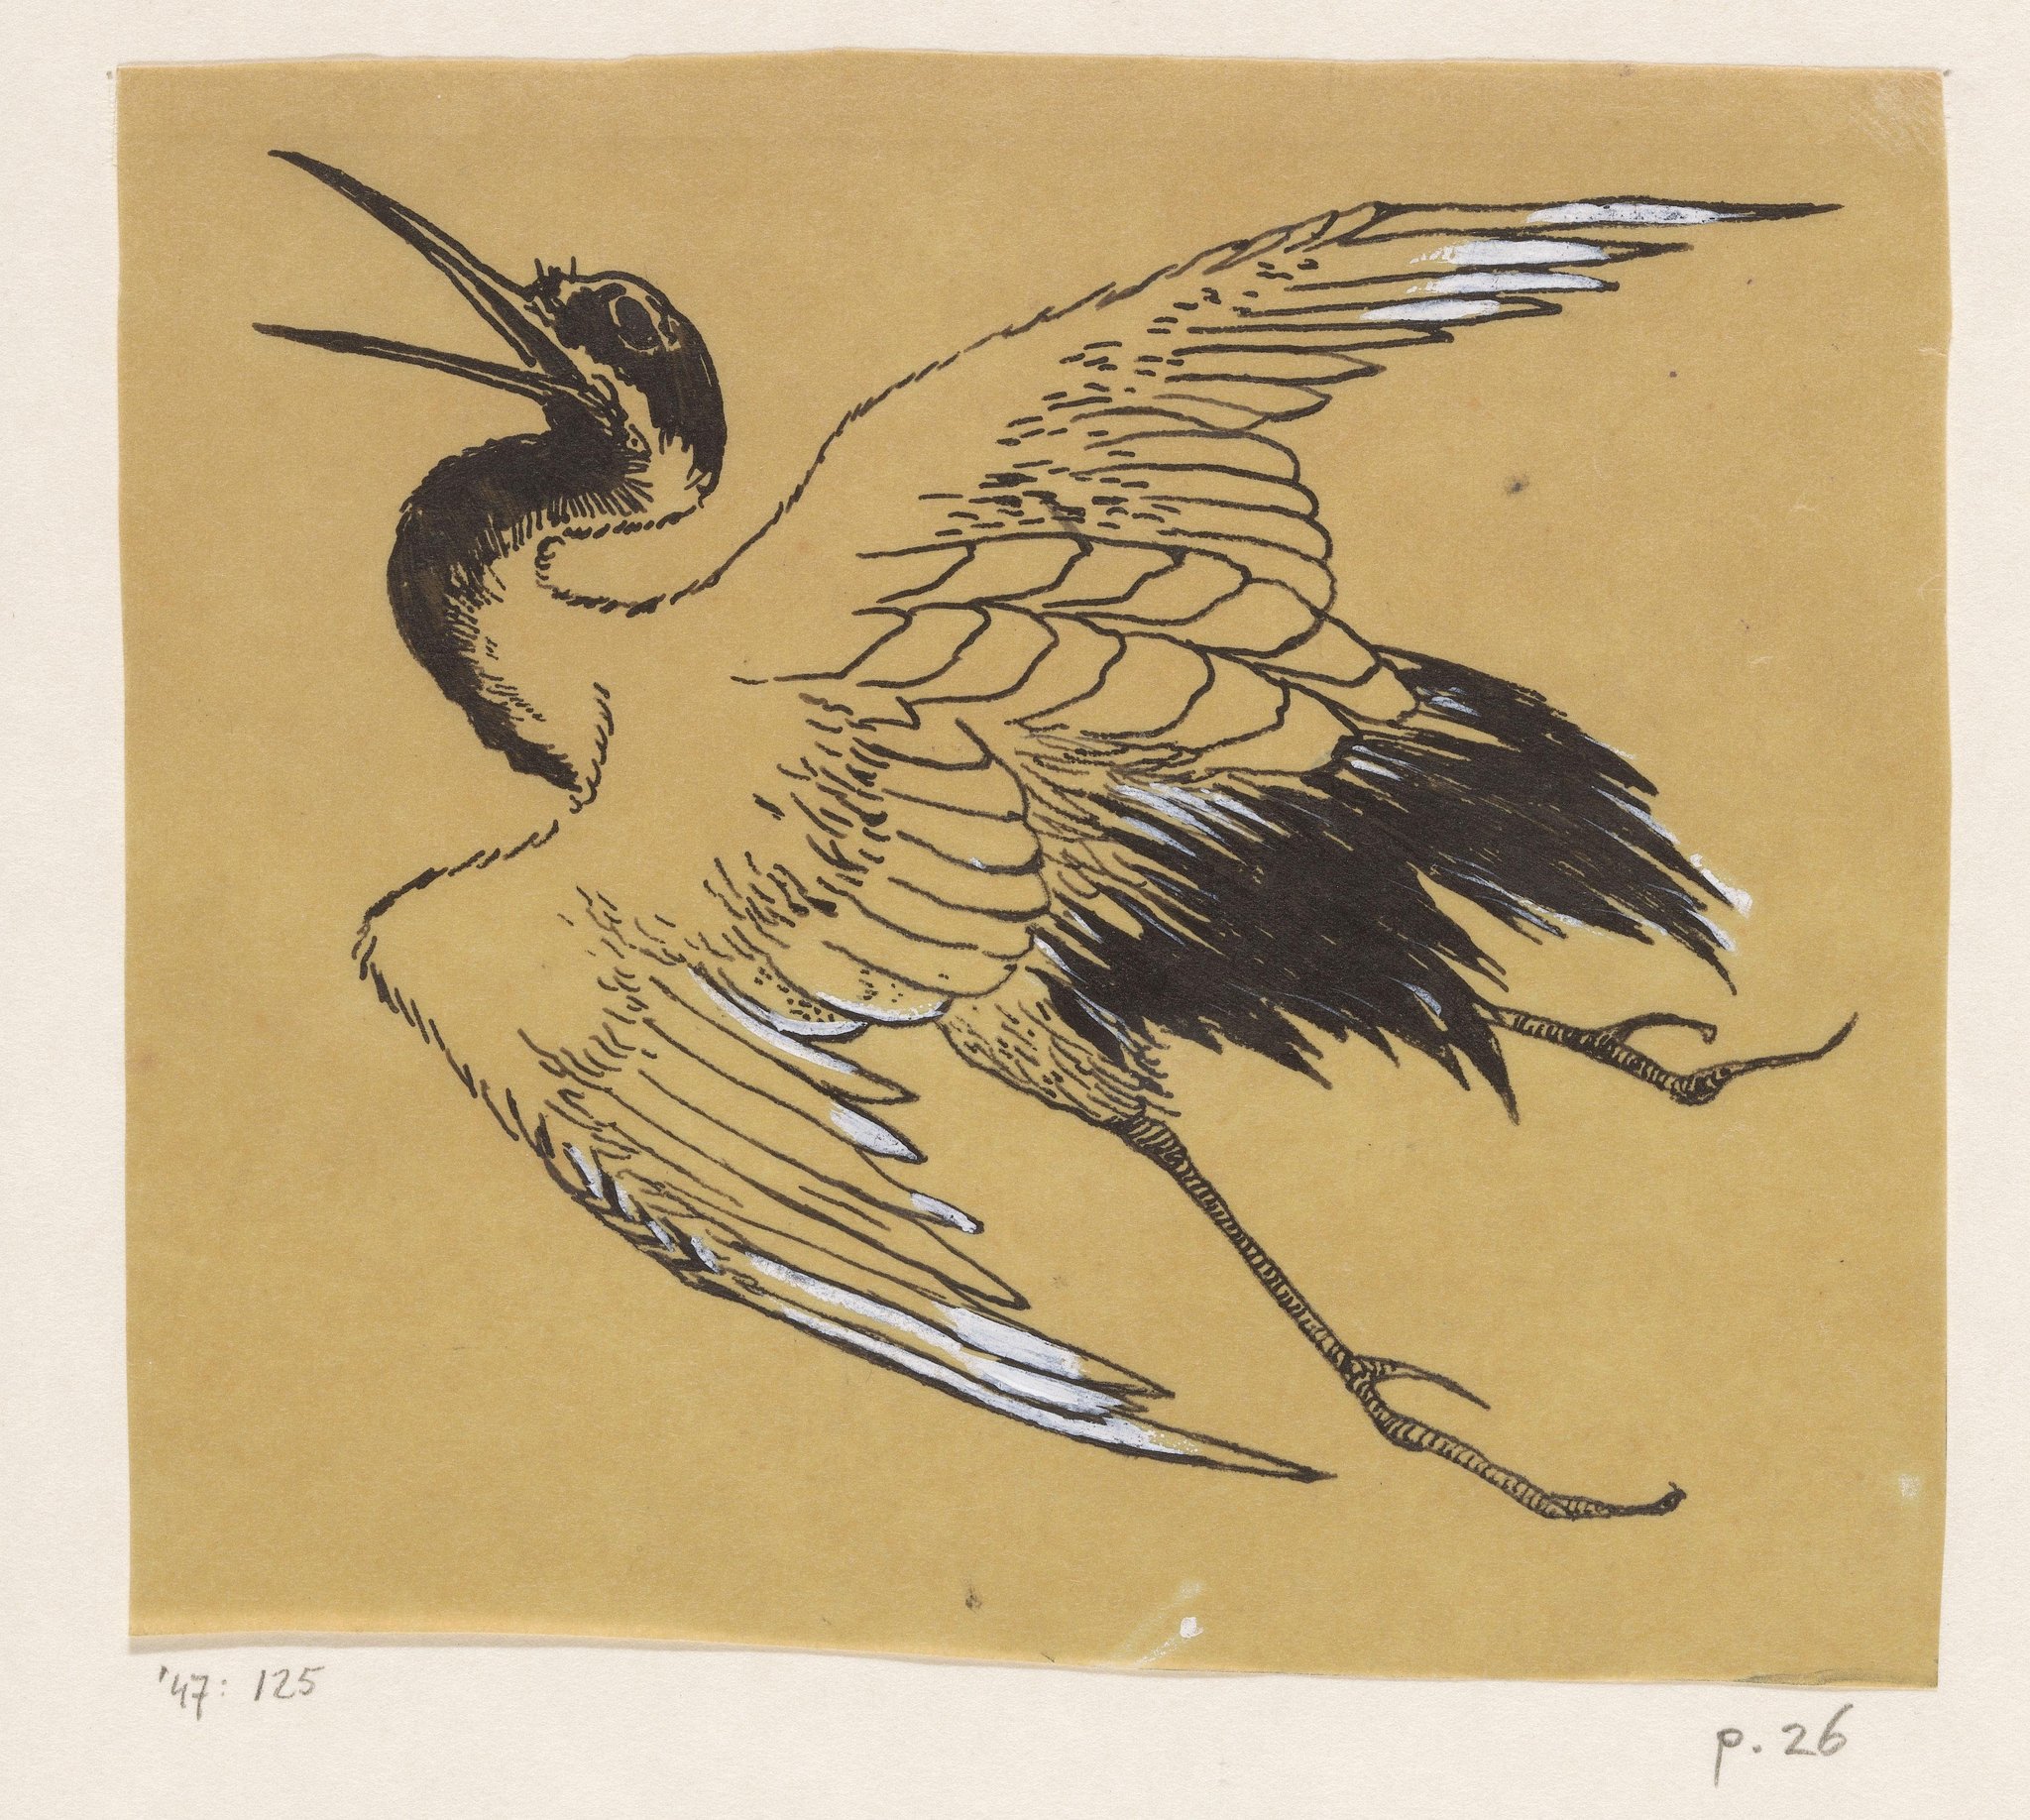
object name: drawing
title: Ooievaar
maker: willem wenckebach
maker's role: designer, draughtsman, painter, print maker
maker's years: 1860-1937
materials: paint, ink, paper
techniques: brush, pen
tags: shore-birds and wading-birds: stork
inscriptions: collector's mark: Lugt 2228a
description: Ontwerp voor: Knappert, Emilie C. Kijkjes in de plantenwereld. Loman & Funke: Amsterdam, 1893.